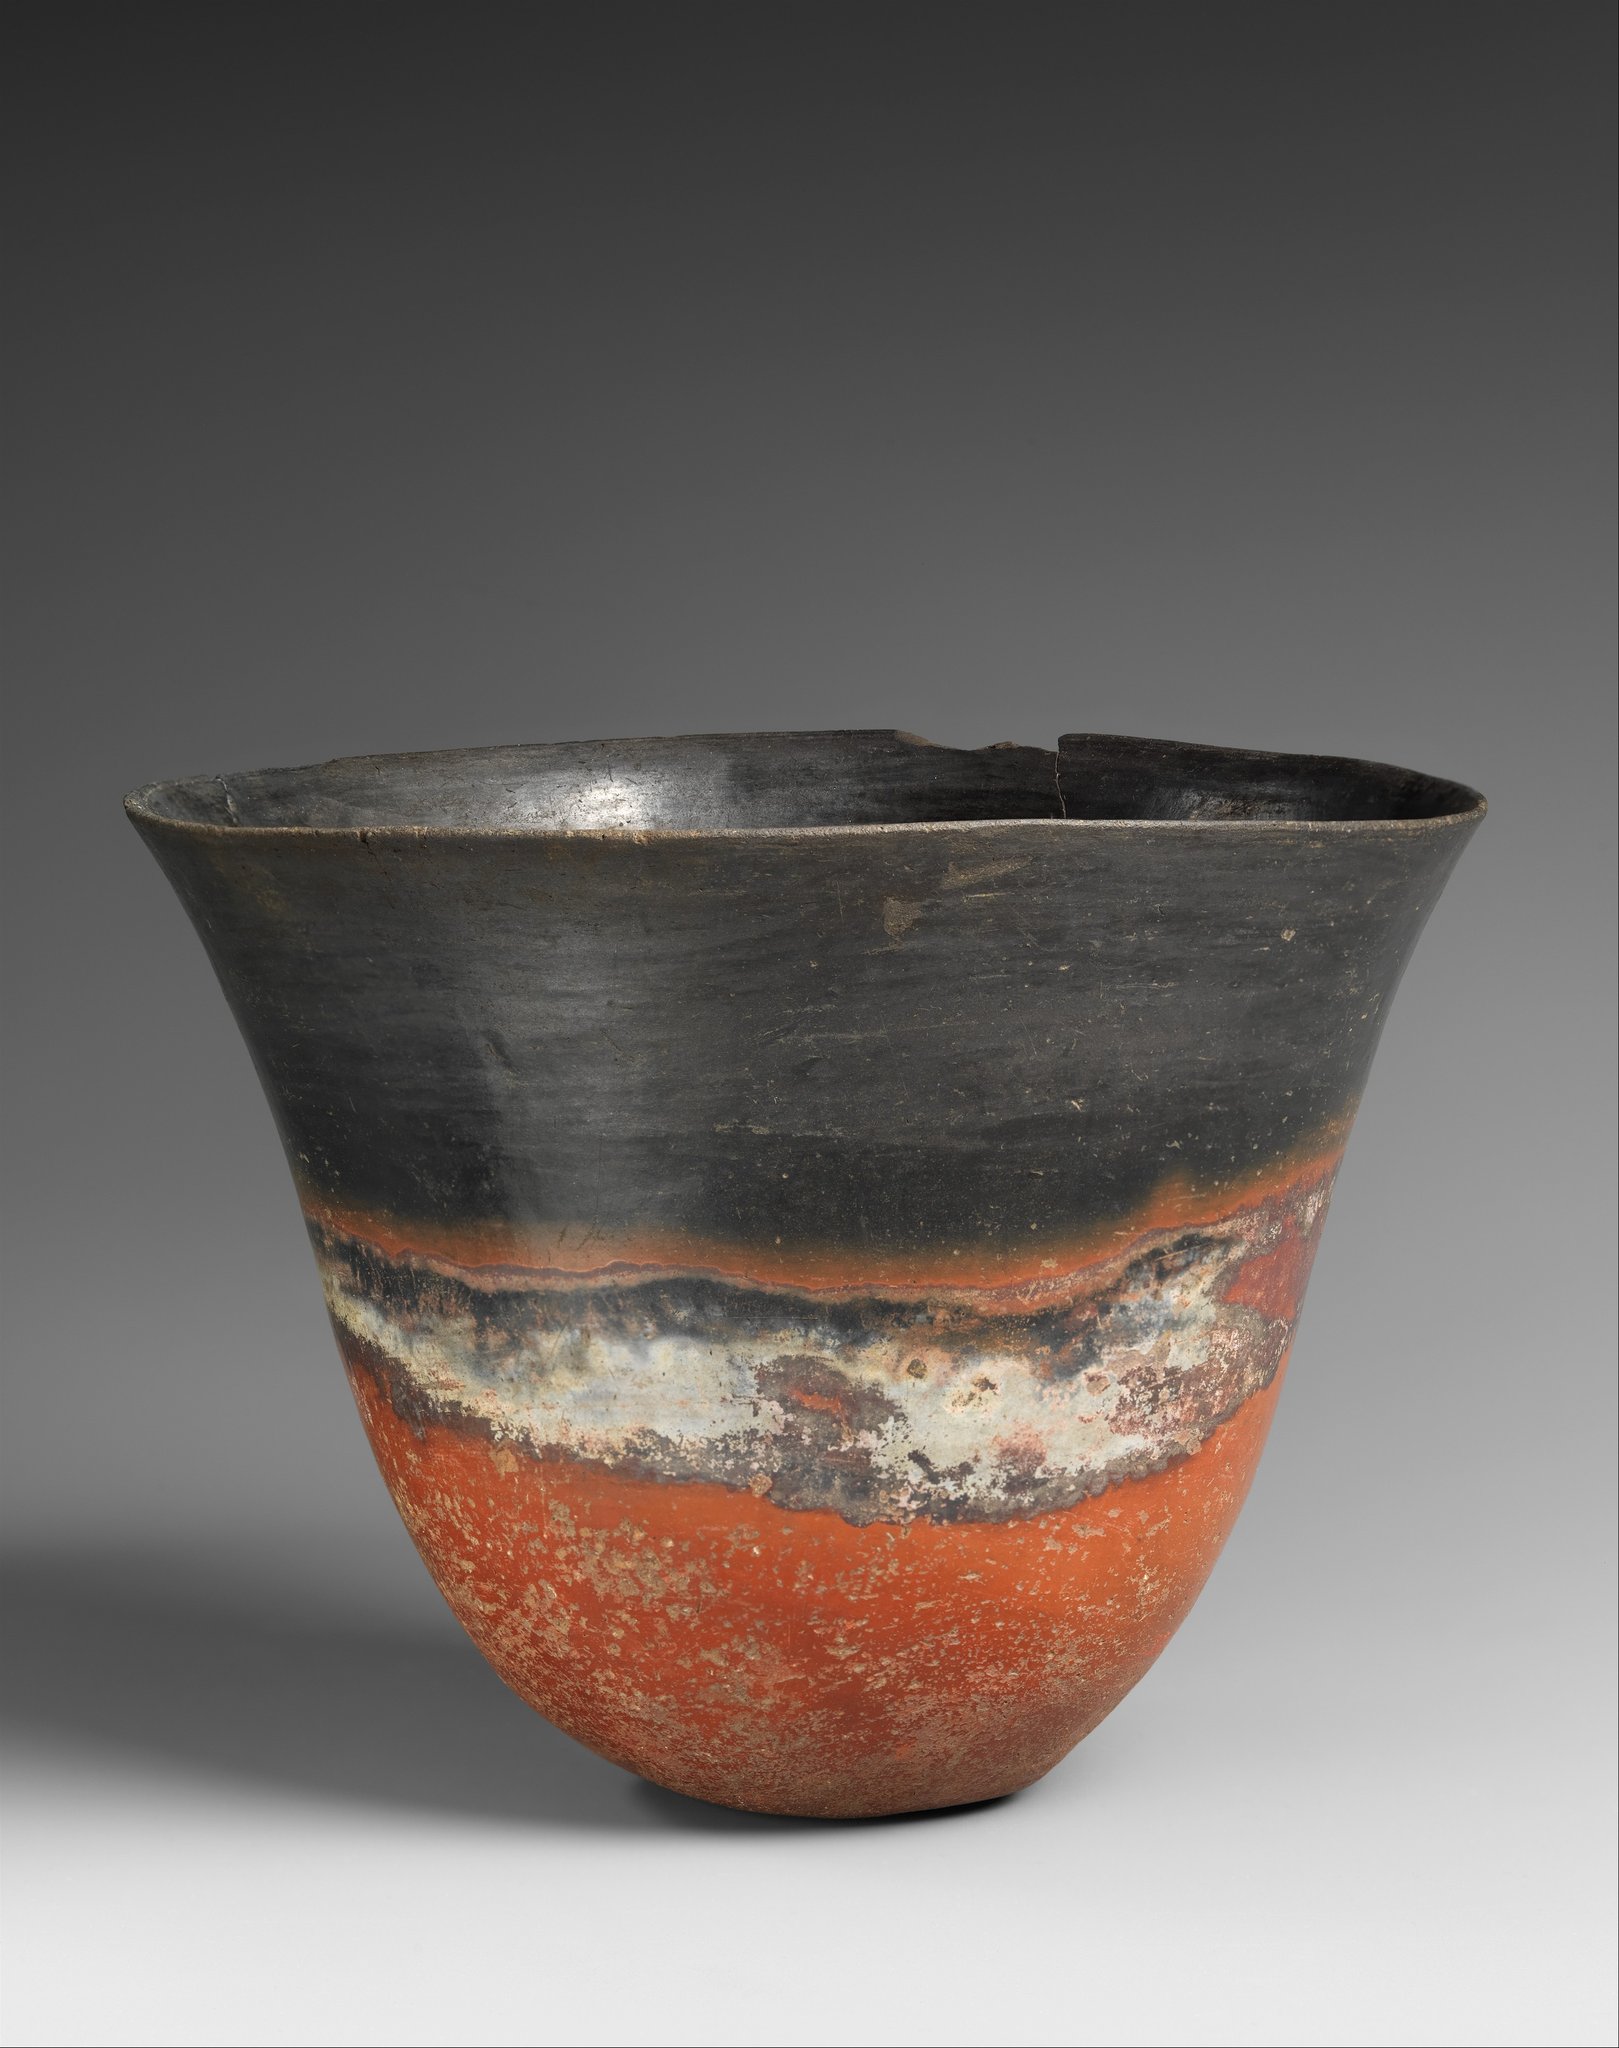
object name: beaker, classic kerma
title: Classic Kerma Beaker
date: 1802-1640 BCE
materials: pottery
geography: egypt